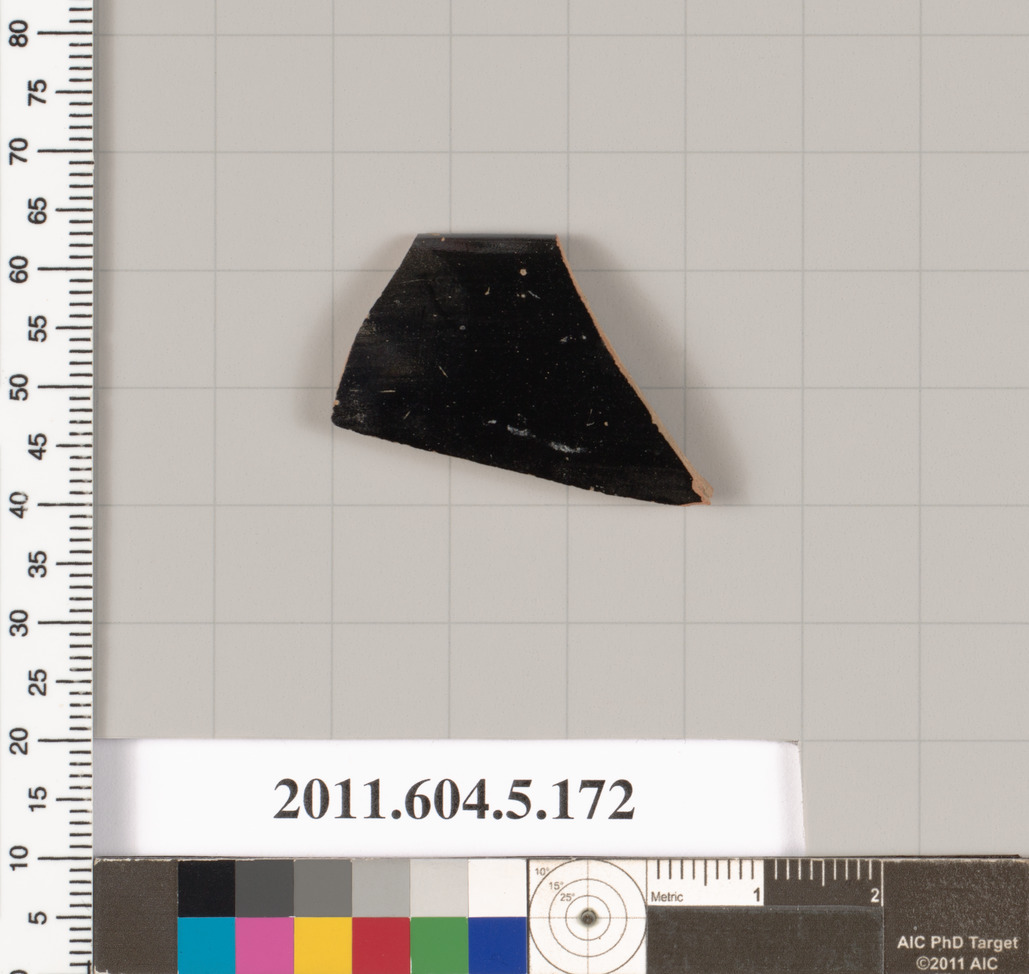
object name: kylix fragment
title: Terracotta rim fragment of a kylix (drinking cup)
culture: greek, attic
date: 600-401 BCE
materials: terracotta